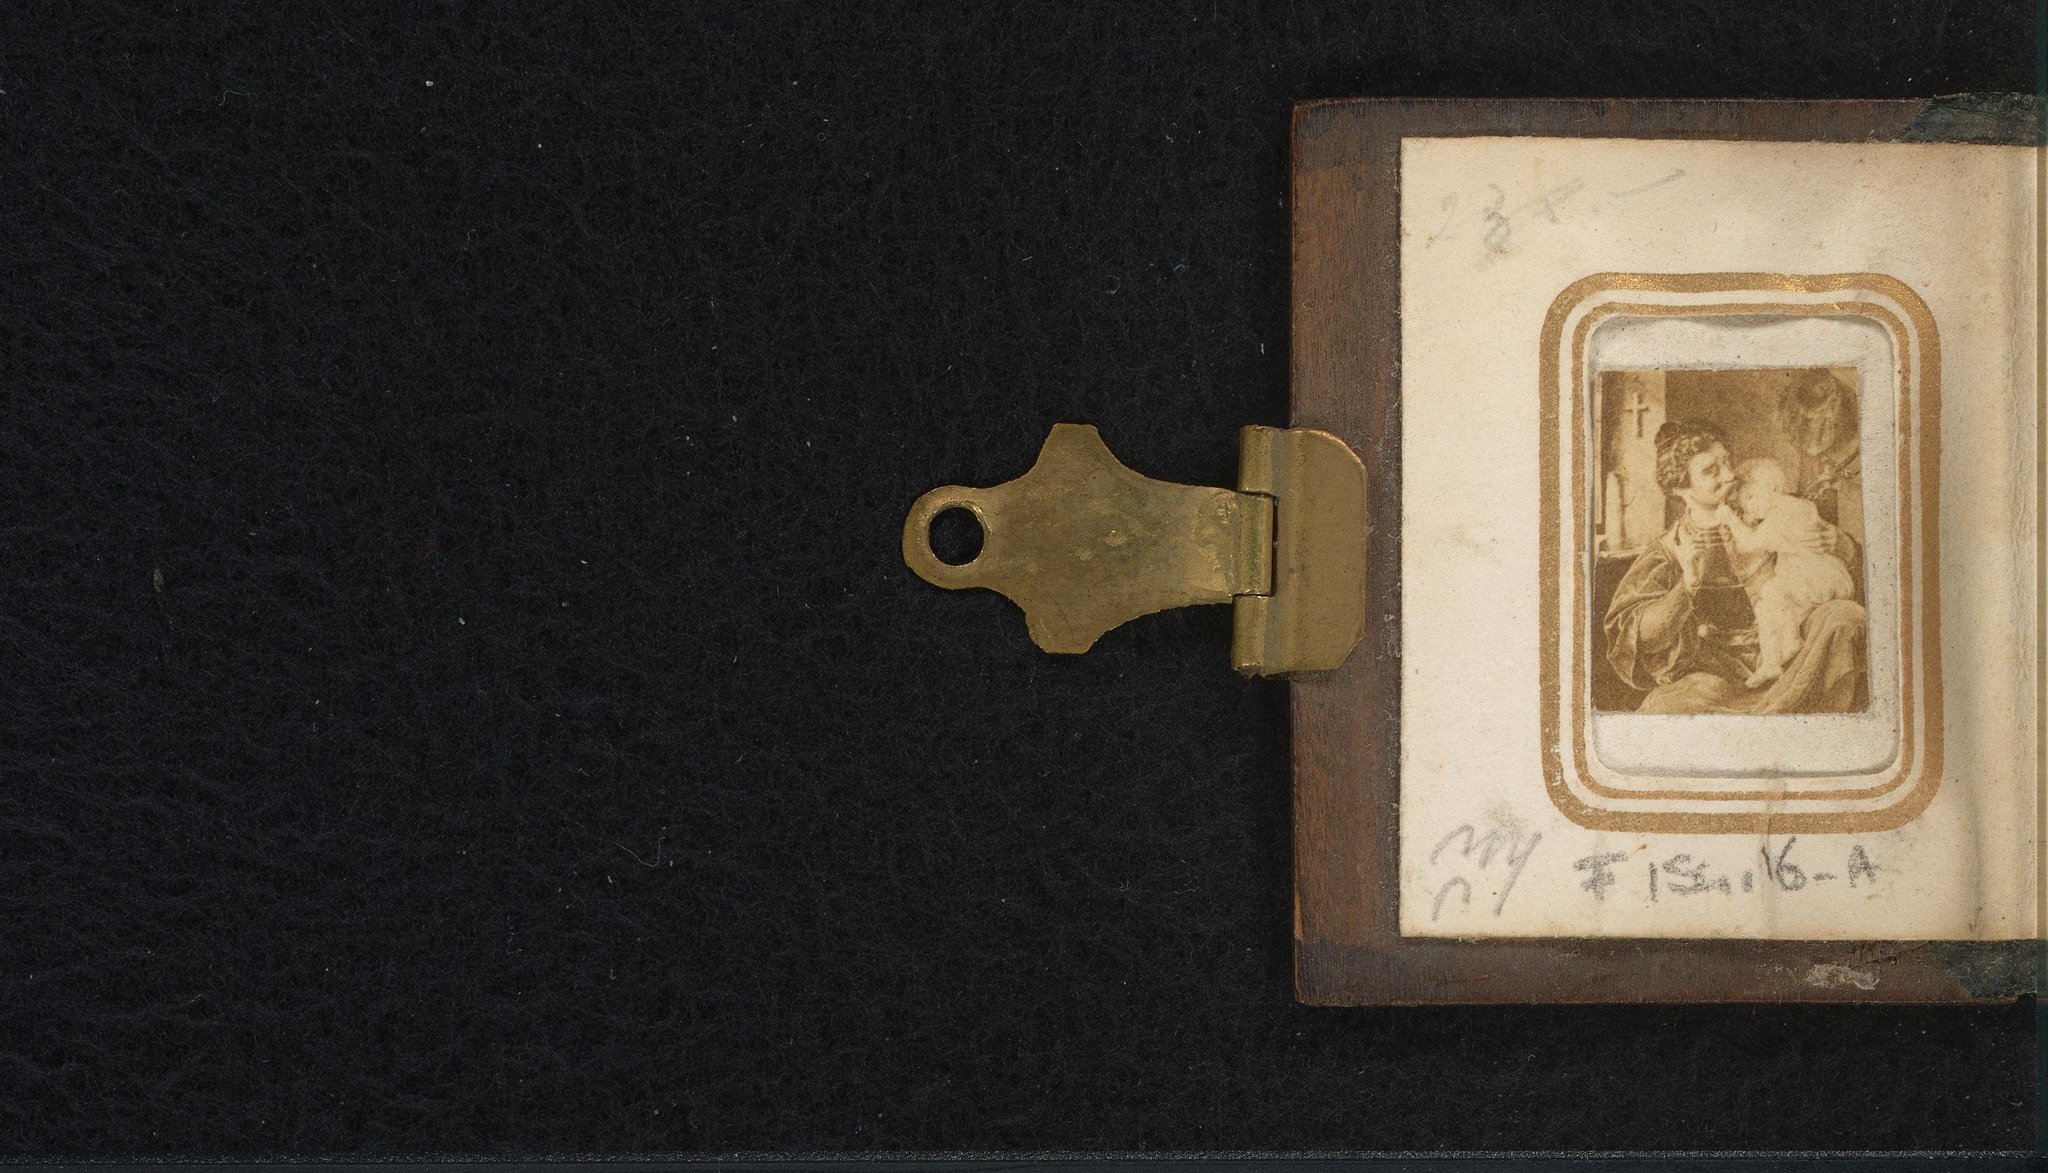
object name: photograph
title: Fotoreproductie van een onbekende man met baby op schoot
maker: Anonymous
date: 1851-1900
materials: paper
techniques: albumen print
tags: adult man, infant, baby